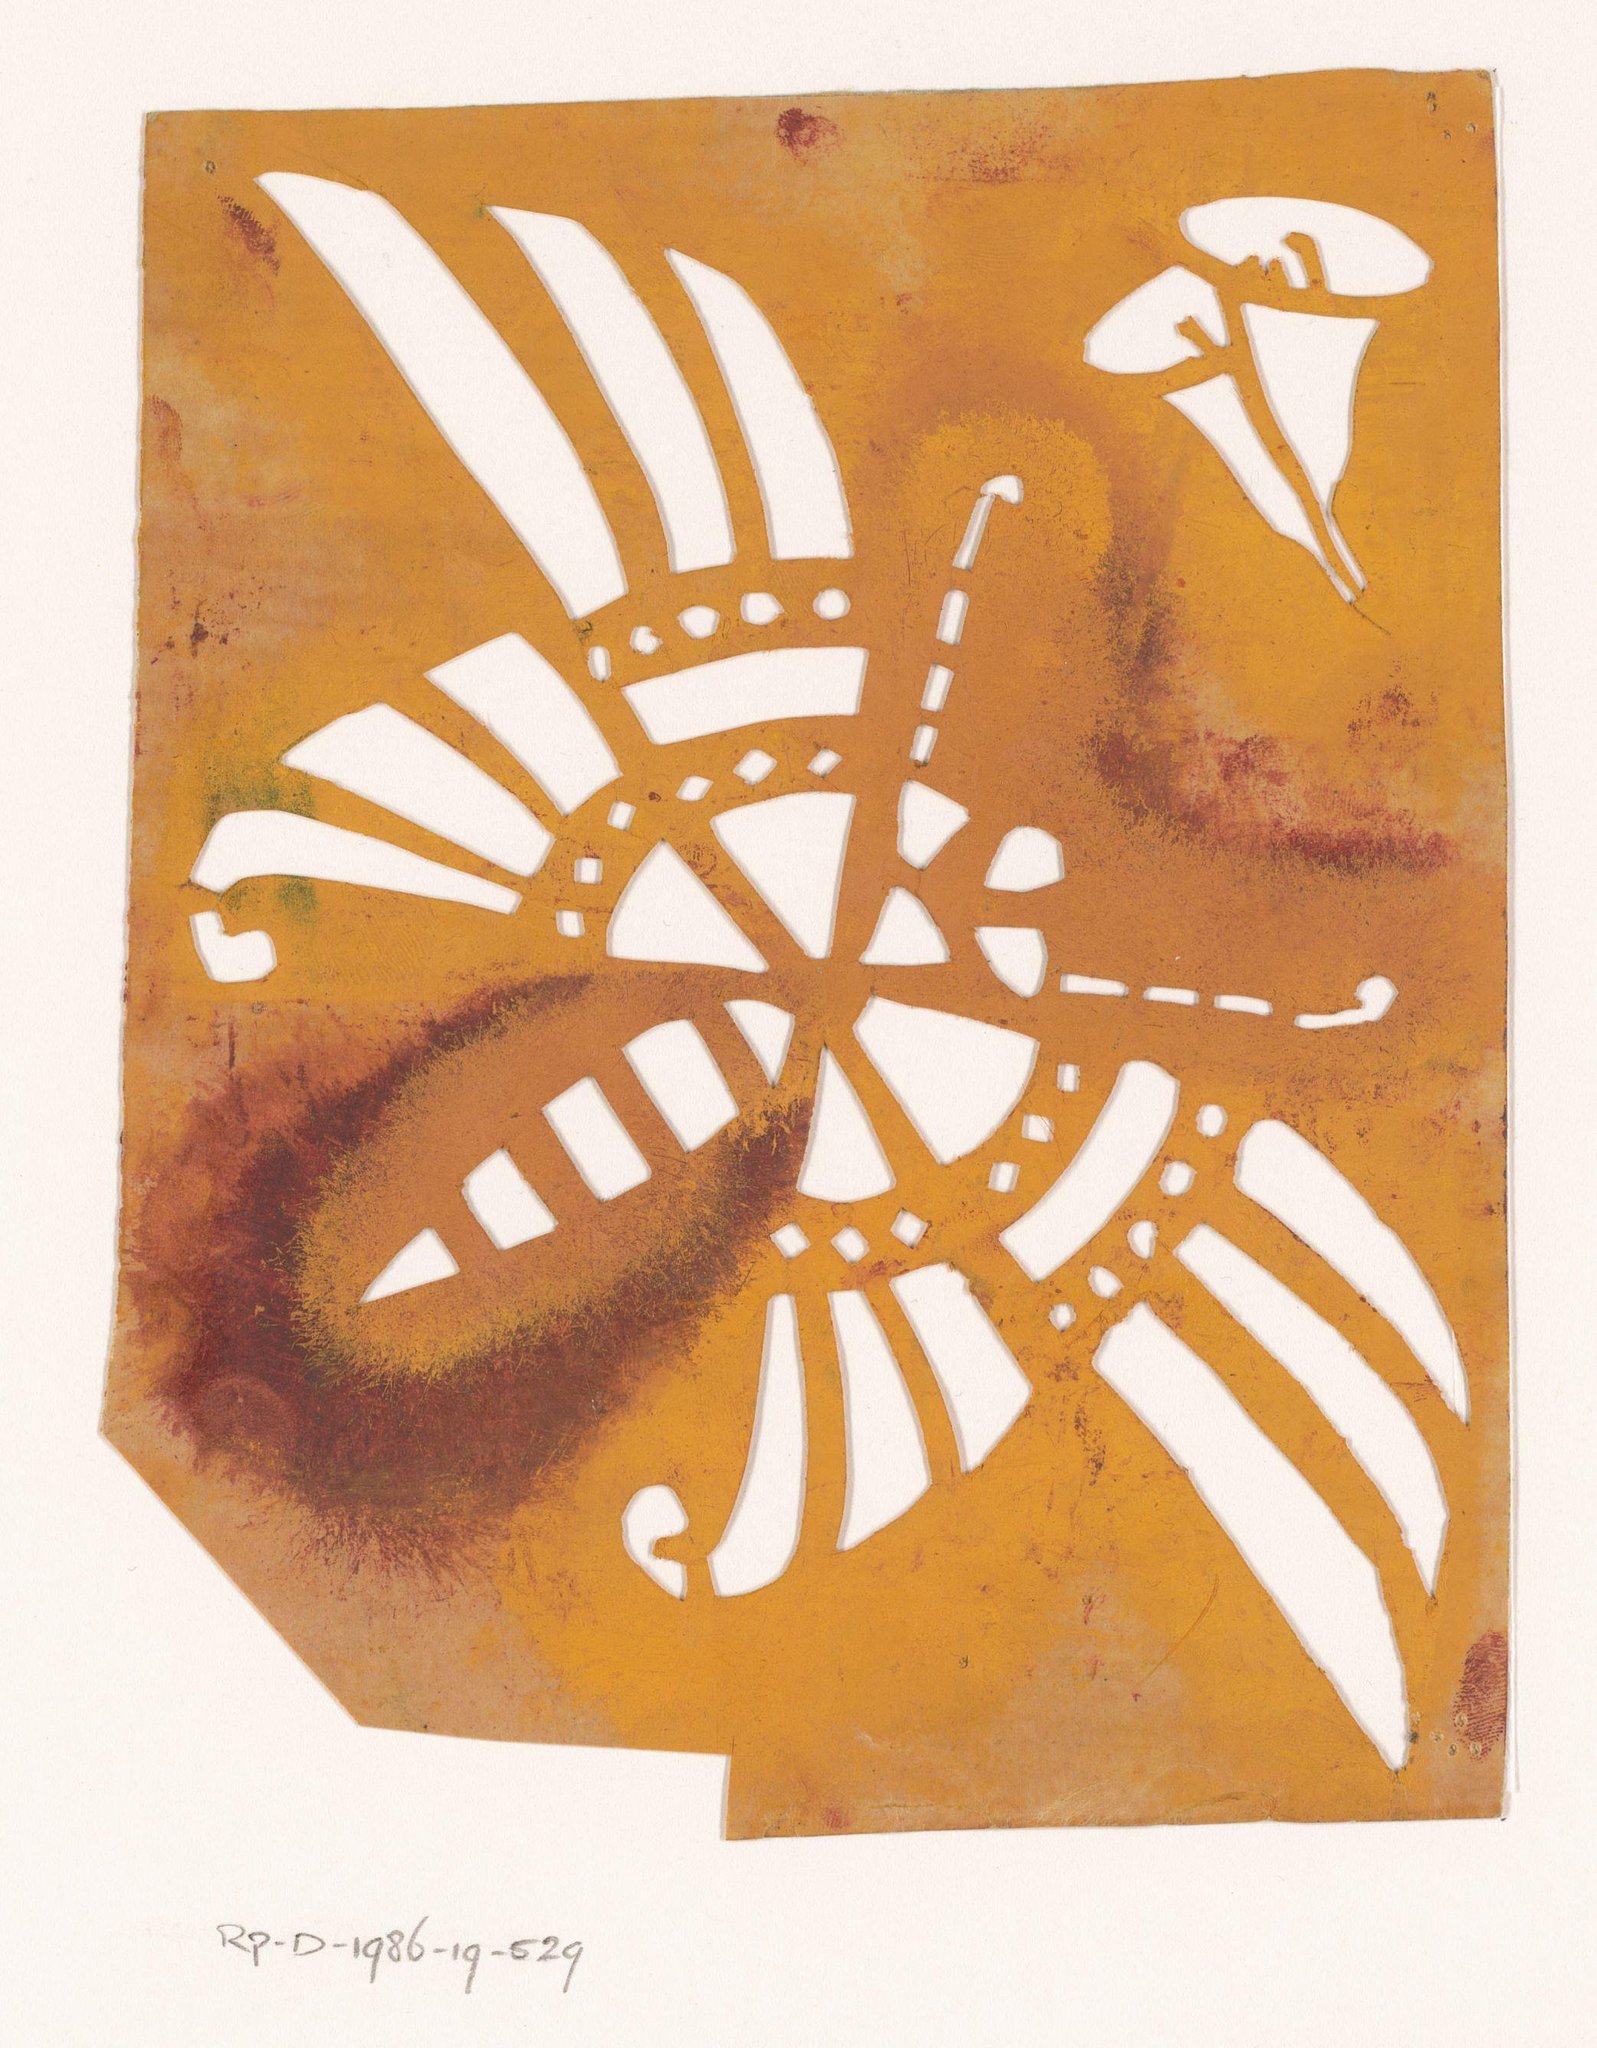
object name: template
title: Sjabloon met vlinder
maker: reinier willem petrus de vries (1874-1953)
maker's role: draughtsman, print maker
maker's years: 1874-1953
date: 1884-1952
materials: paper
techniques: cutting, snipping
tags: insects: butterfly